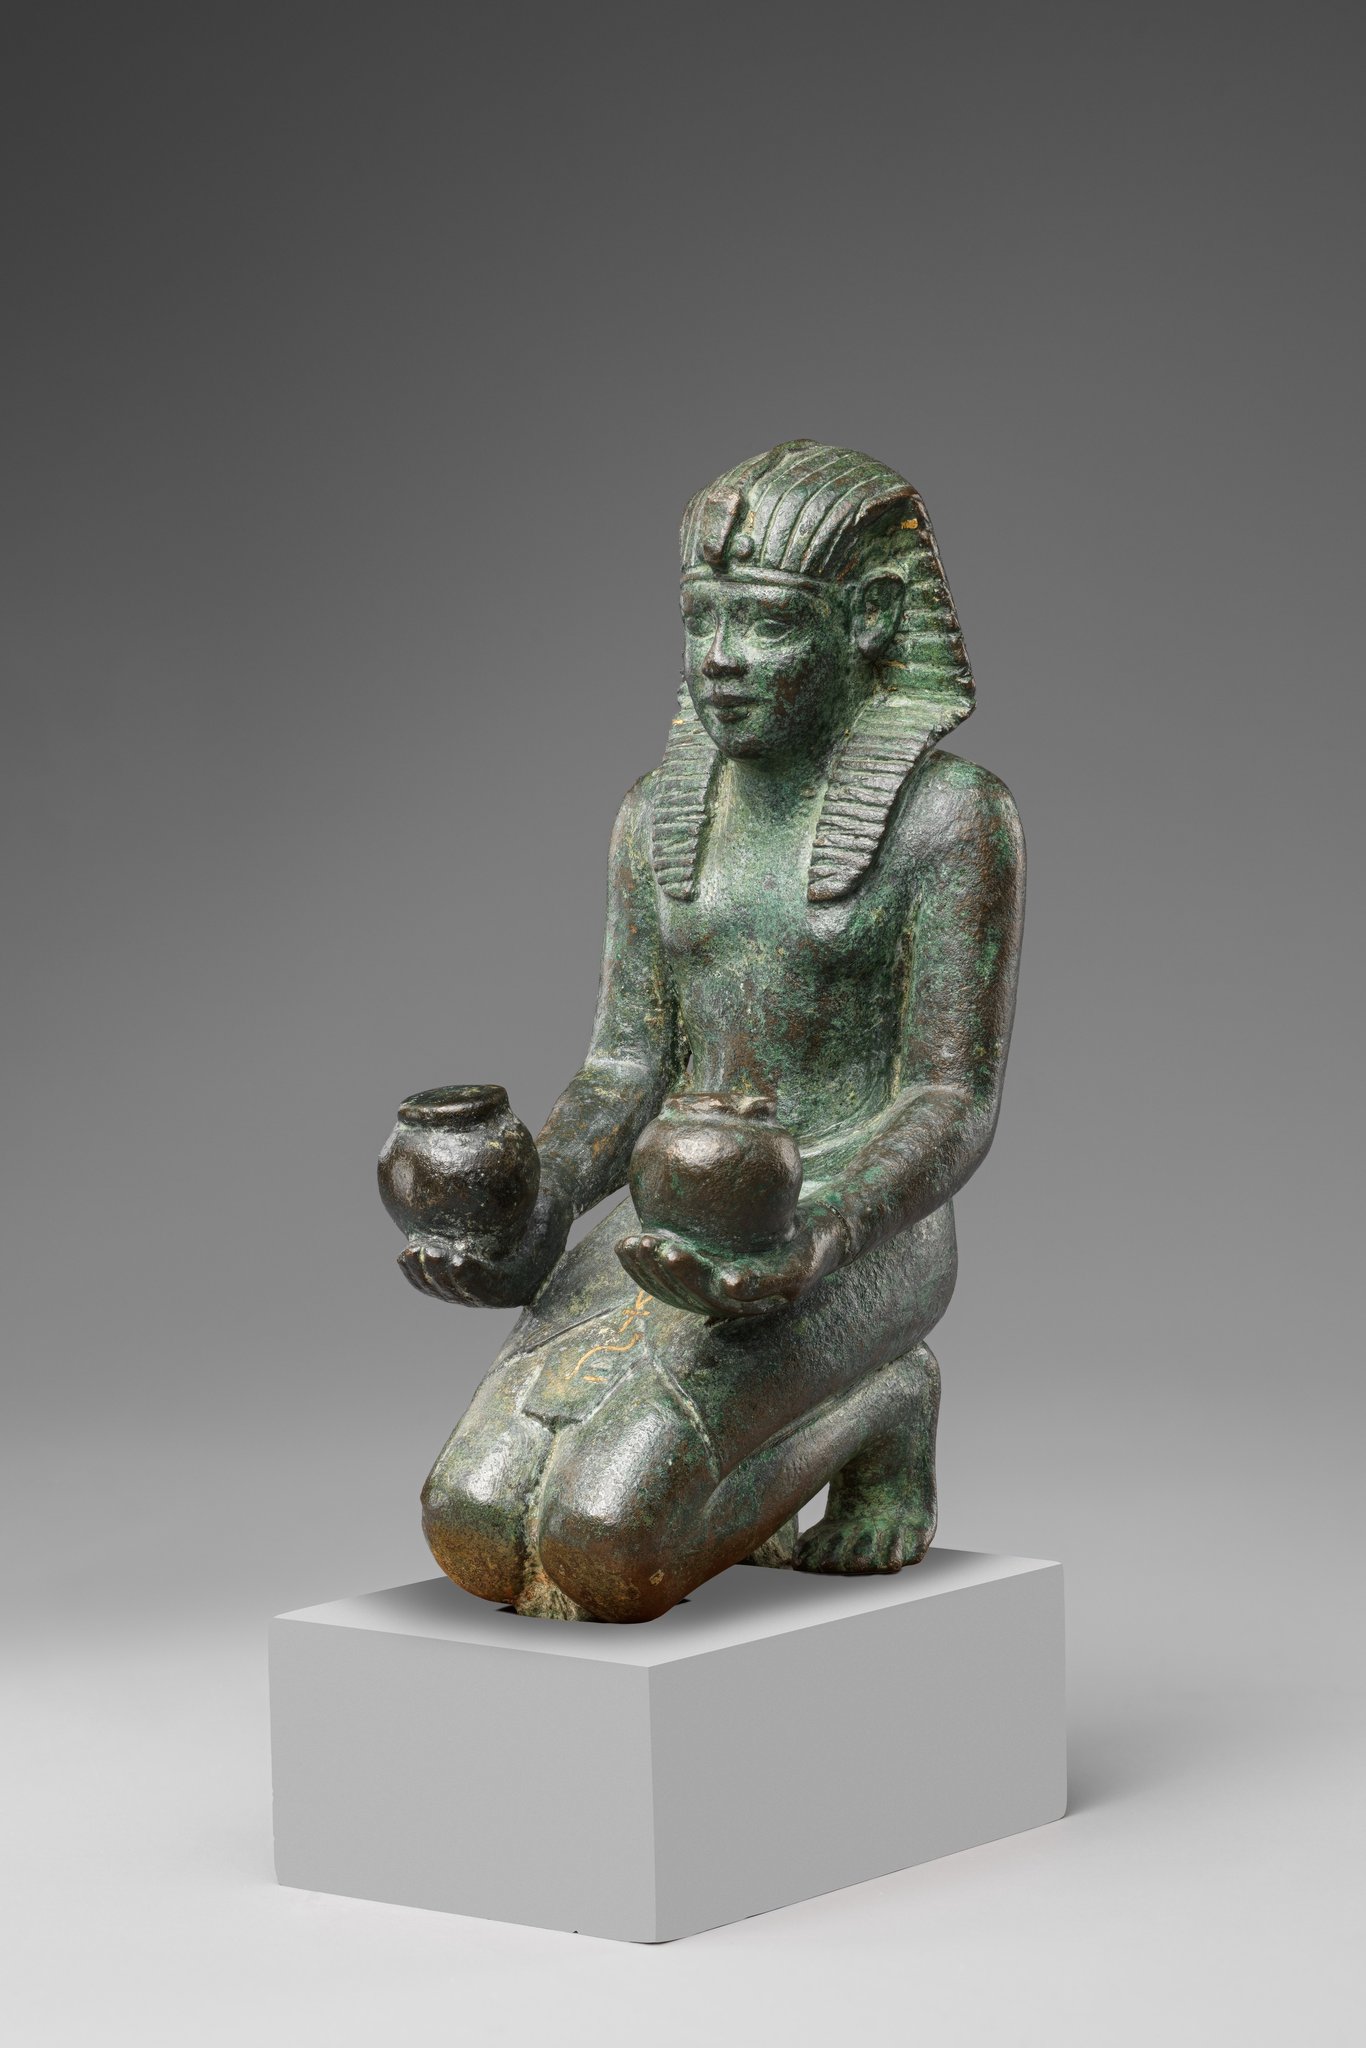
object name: statuette, kneeling king, king amasis kneeling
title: Kneeling statuette of King Amasis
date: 570-526 BCE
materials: bronze, metal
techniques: inlay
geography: egypt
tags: kings